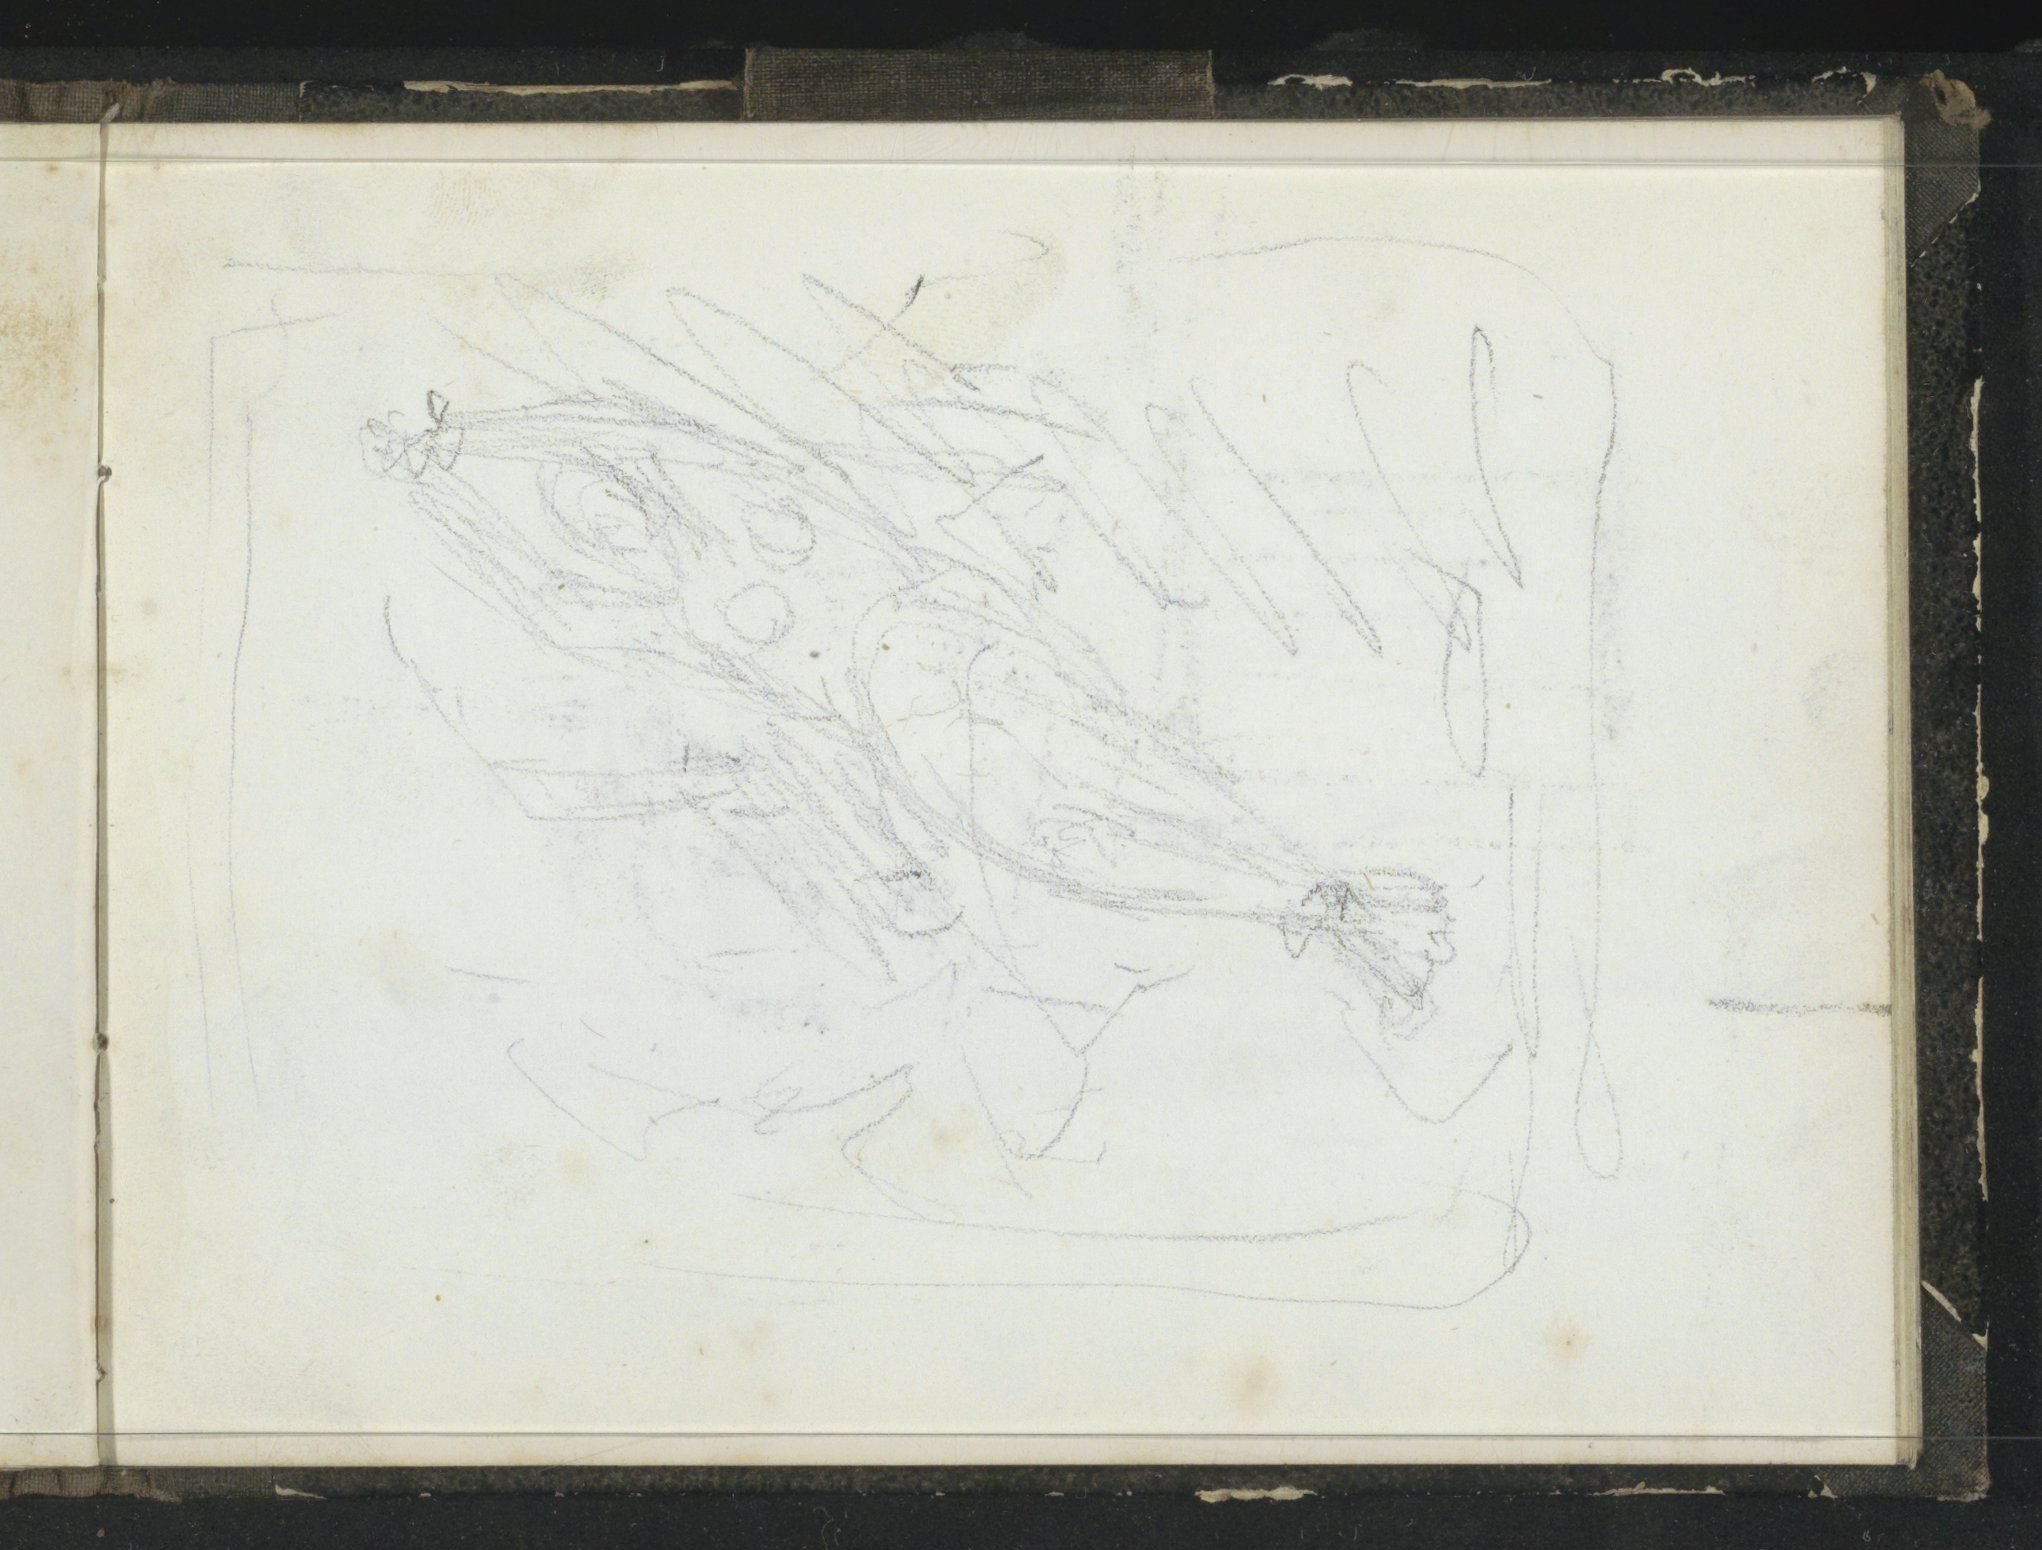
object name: sketchbook leaf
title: Liggende vrouw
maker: theo hanrath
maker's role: draughtsman, painter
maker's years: 1853-1883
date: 1879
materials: paper, pencil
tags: lying figure - aa - female human figure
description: De polsen en enkels van vrouw zijn mogelijk samengebonden. Blad 18 recto uit een schetsboek met 27 bladen.